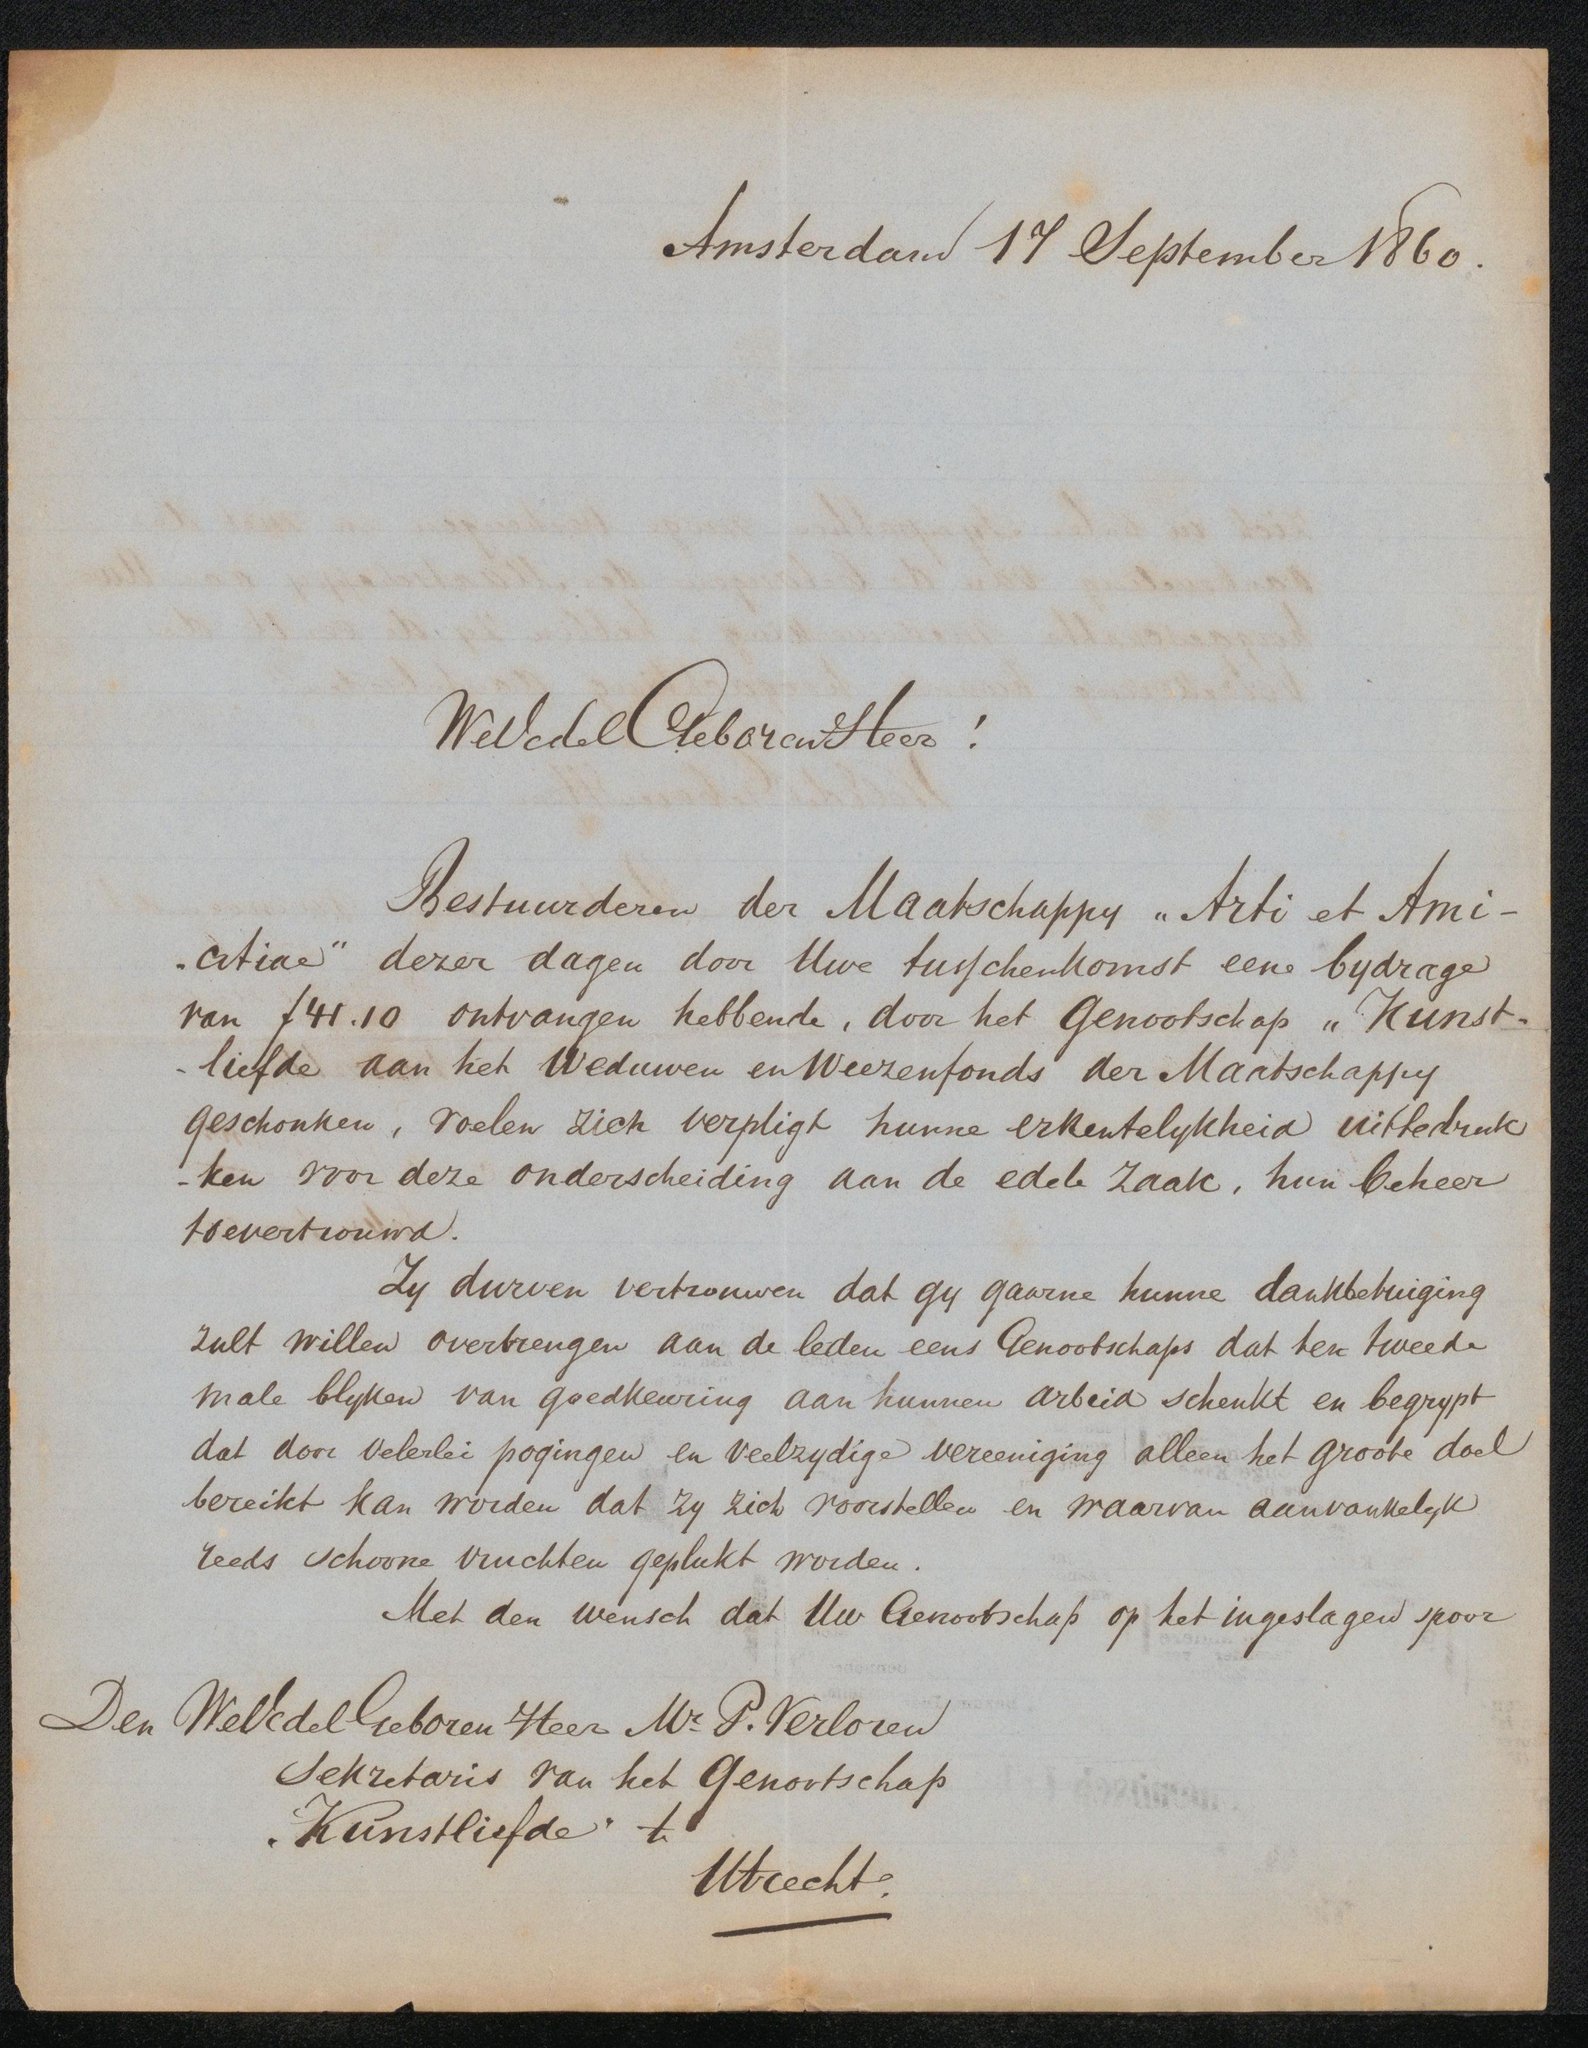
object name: letter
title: Brief aan Pieter Verloren van Themaat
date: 1860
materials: ink, paper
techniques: pen, writing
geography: amsterdam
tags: utrecht, pieter verloren van themaat, charitable works, money